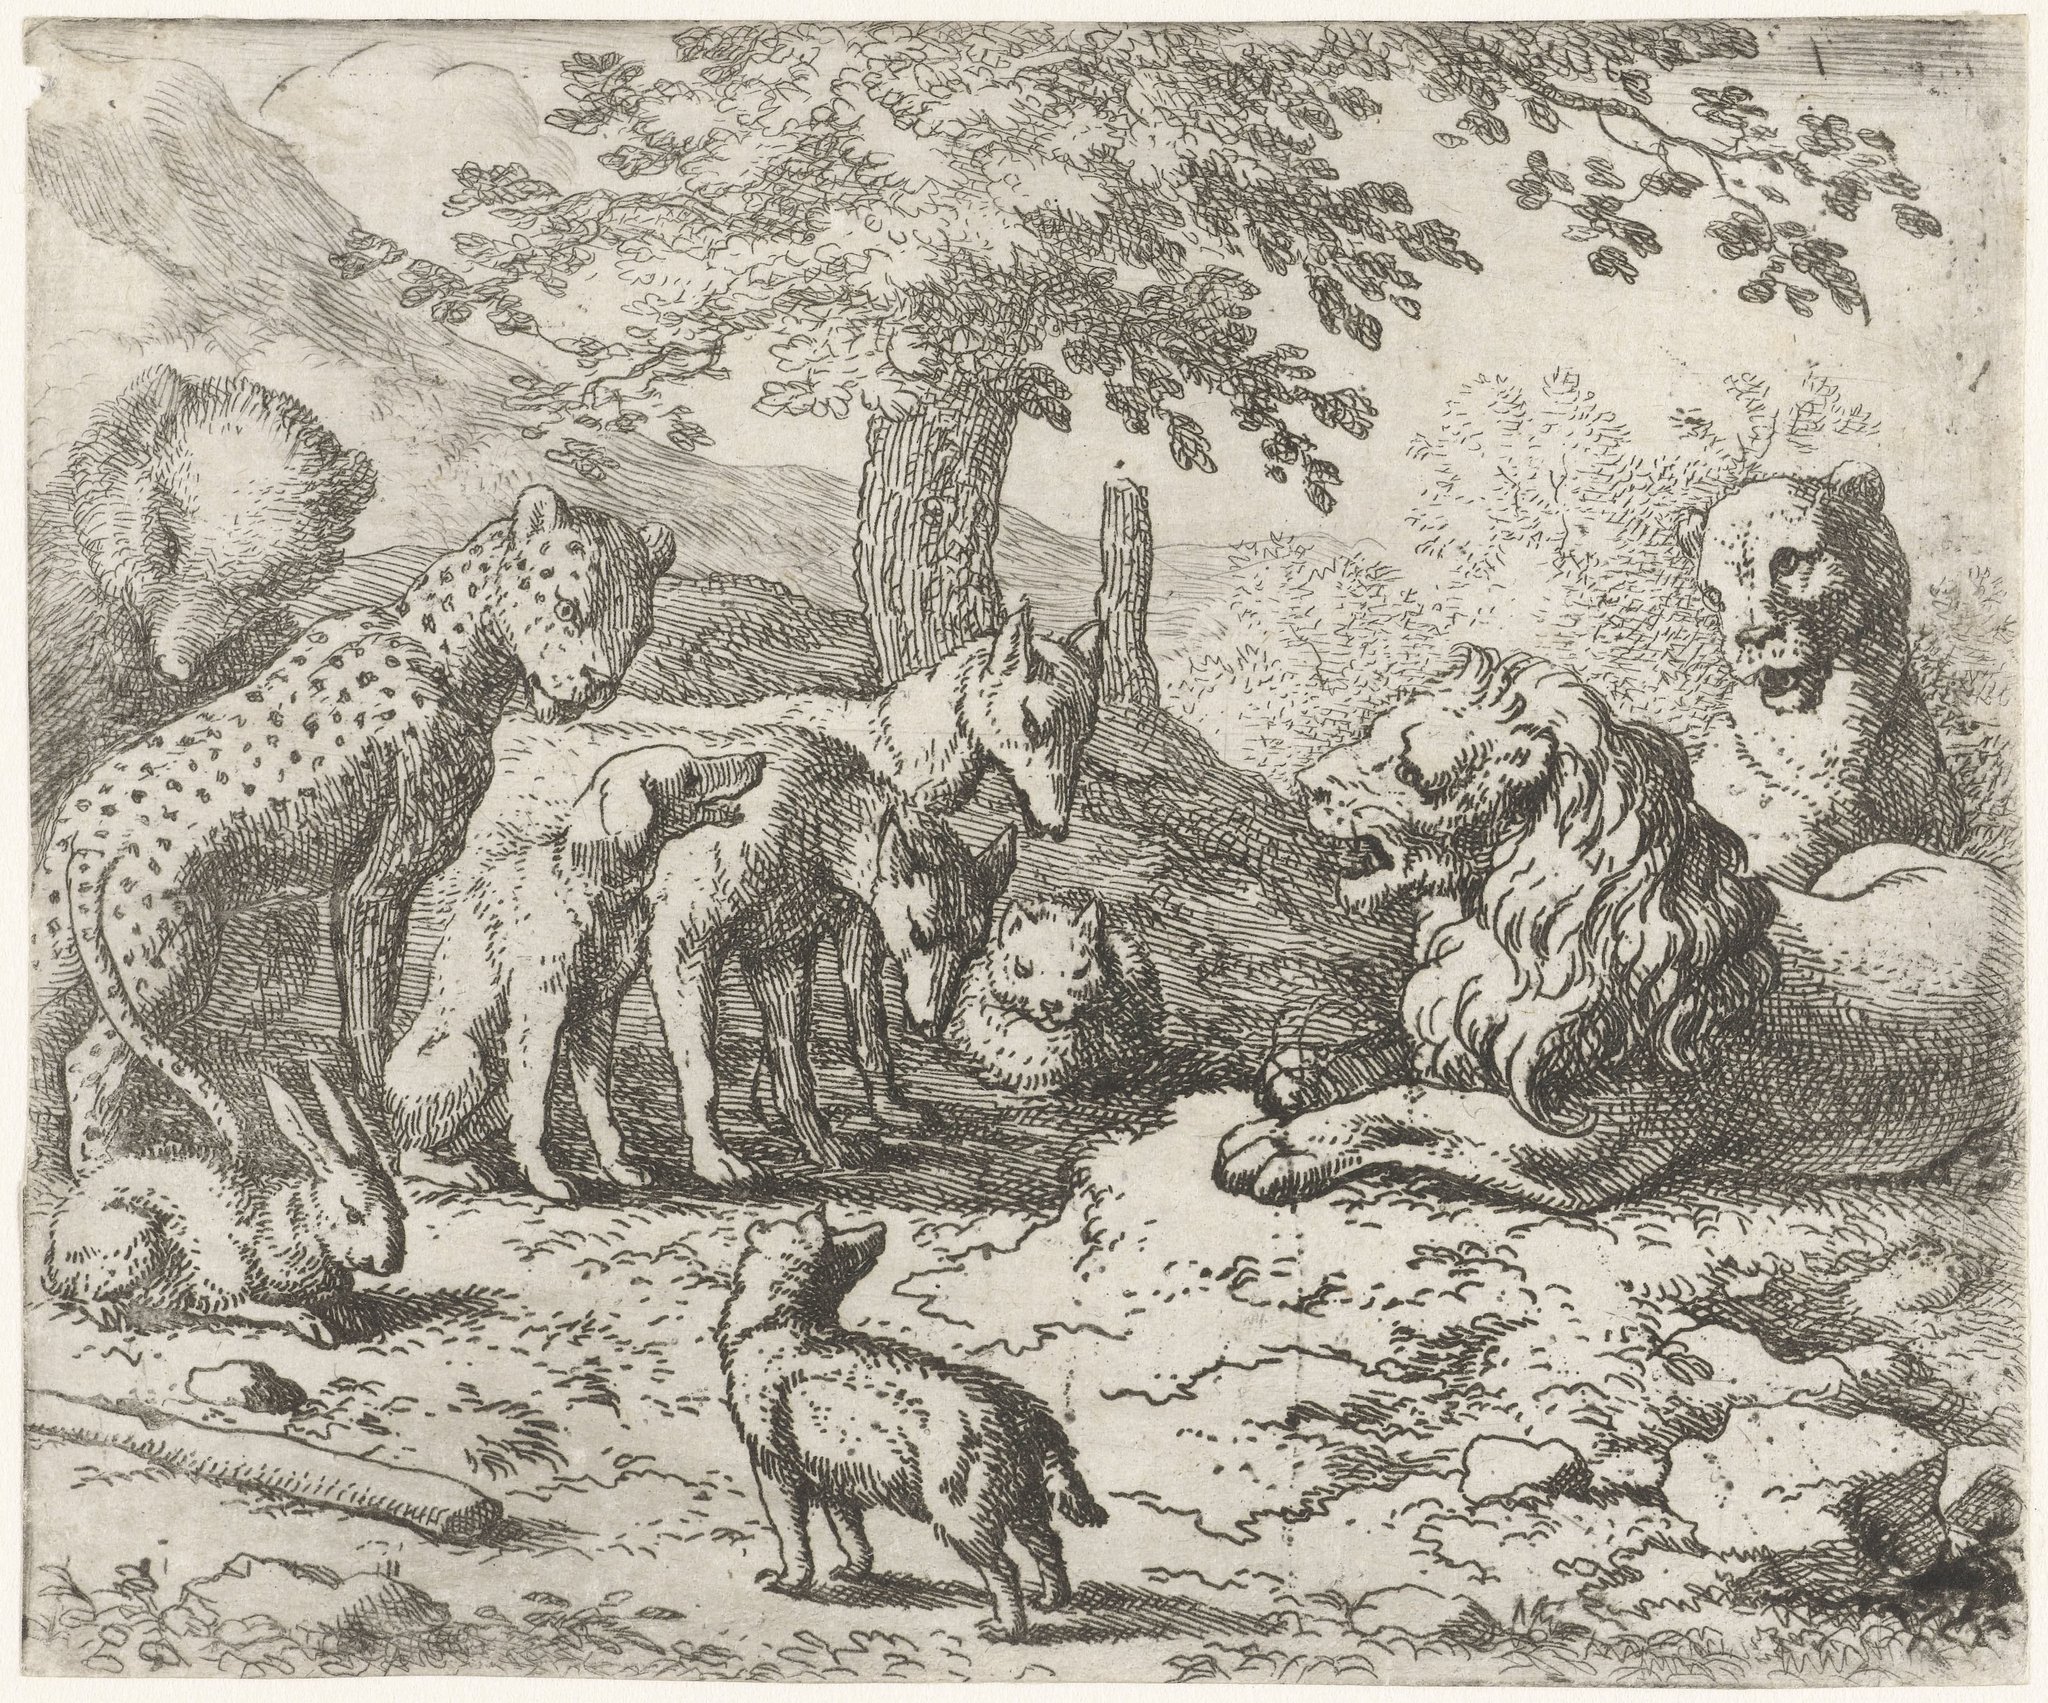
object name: print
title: Reinaert de vos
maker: allaert van everdingen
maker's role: draughtsman, painter, print maker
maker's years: 1621-1675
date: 1665-1675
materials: paper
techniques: etching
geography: netherlands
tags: fable of reynard the fox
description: De leeuw, koning Nobel, beraadslaagt met de andere dieren, waaronder Fyrapeel het luipaard, Bruun de beer en Cuwaert het konijn.